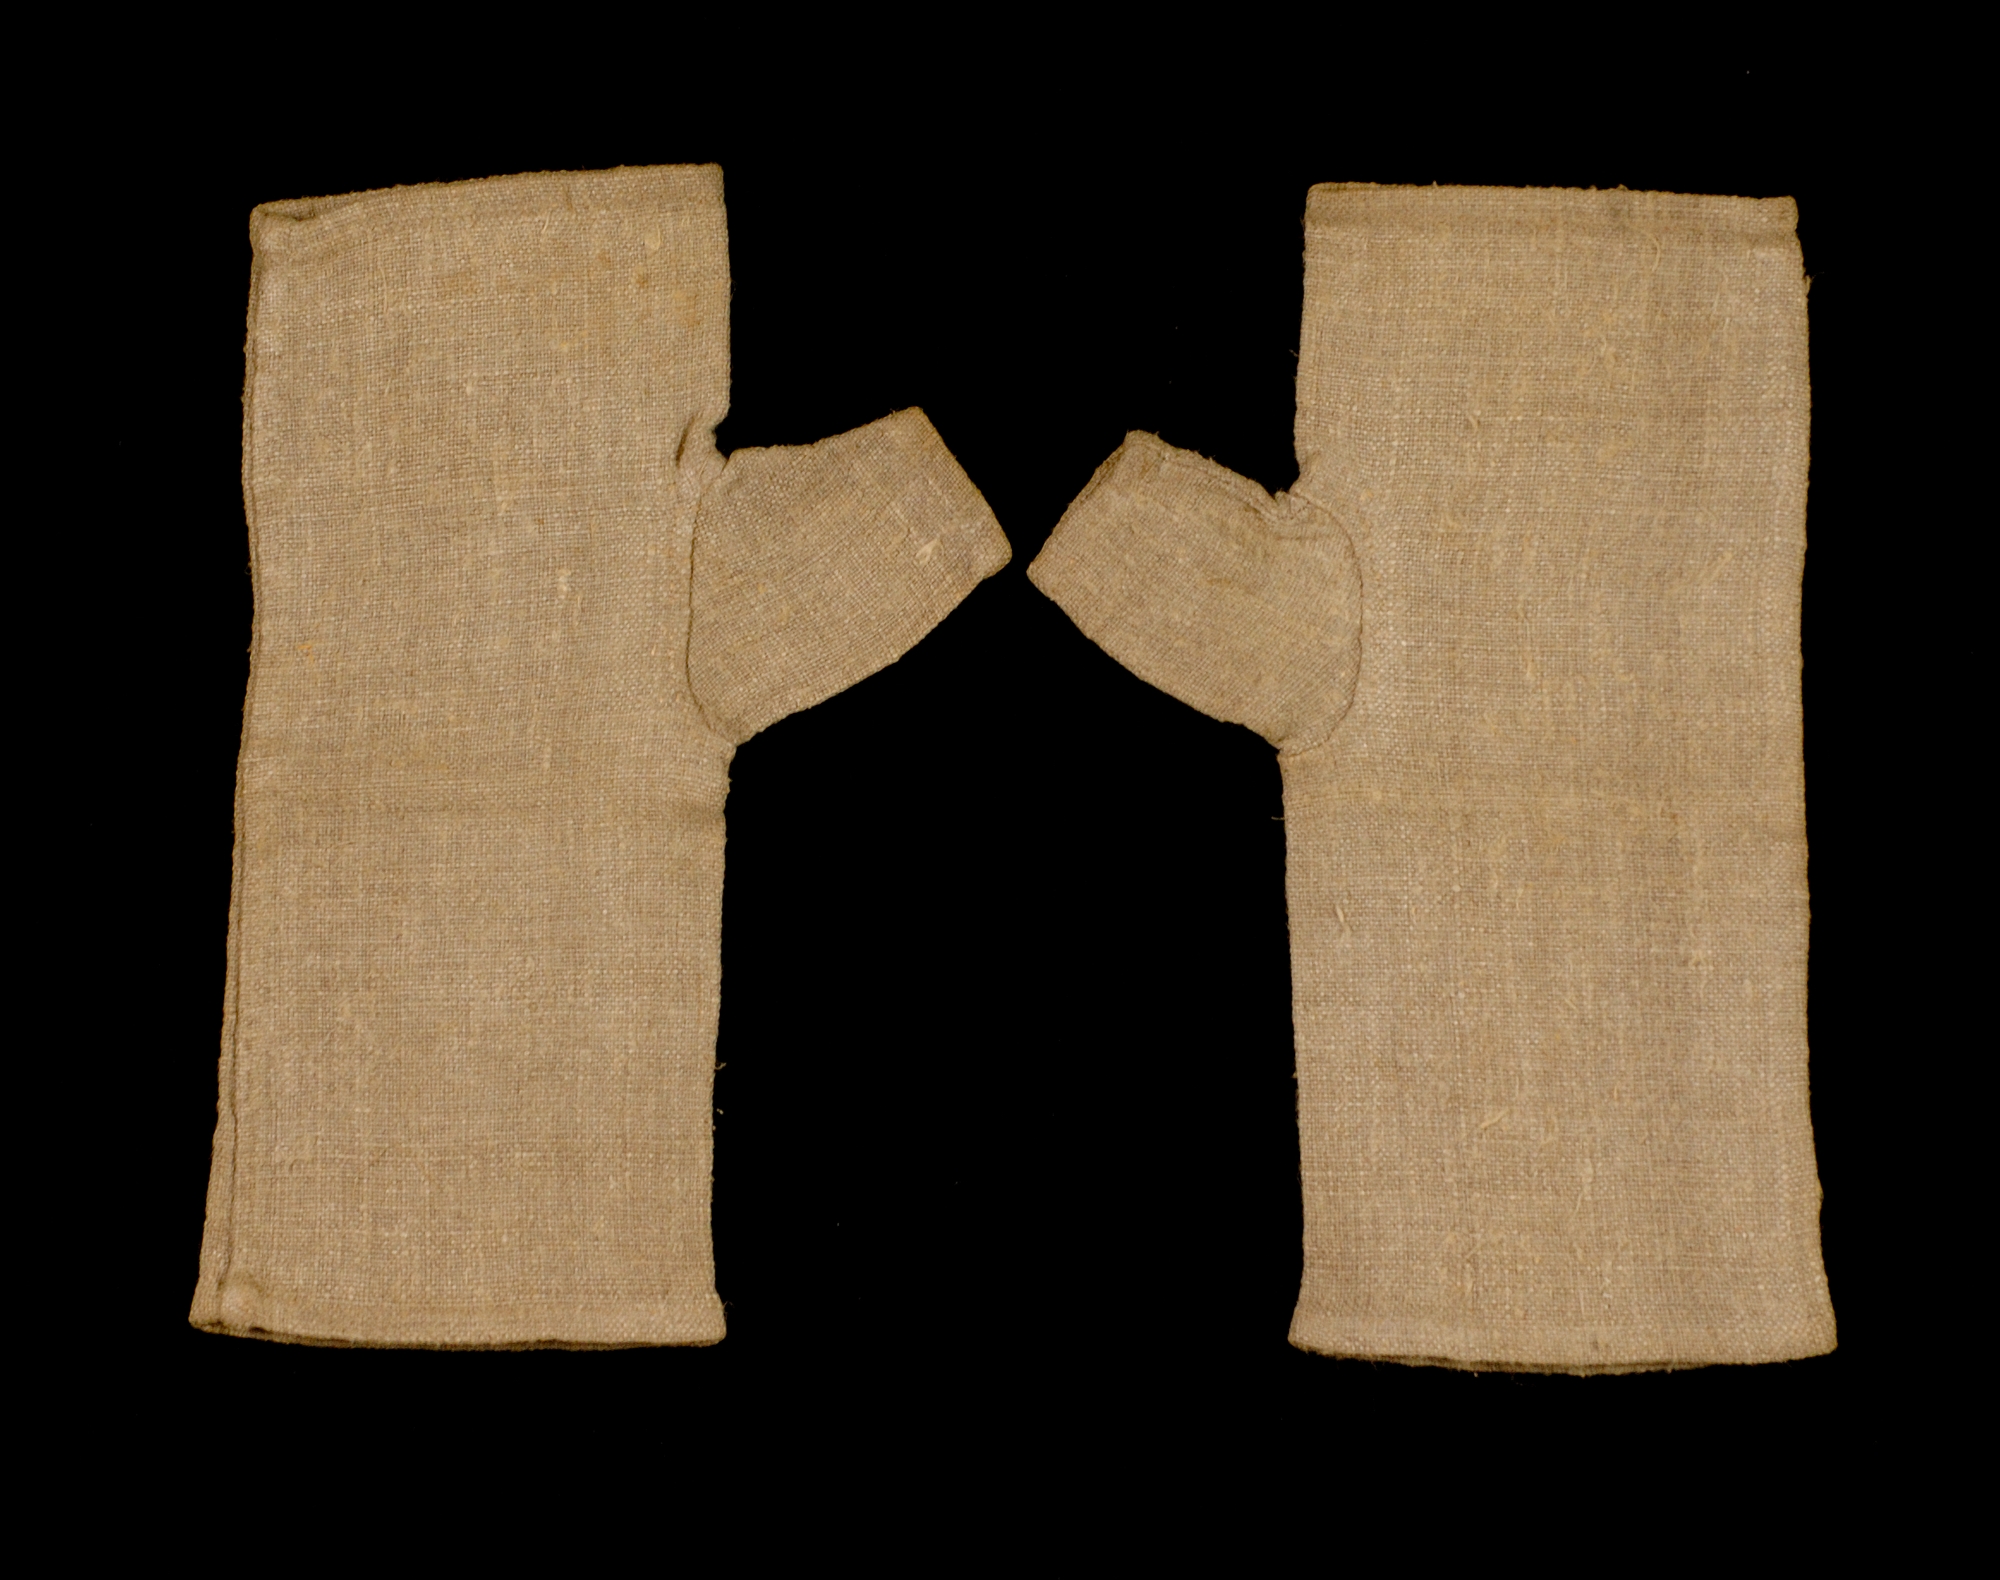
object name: mitt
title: Mitts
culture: american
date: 1826-1850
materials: linen